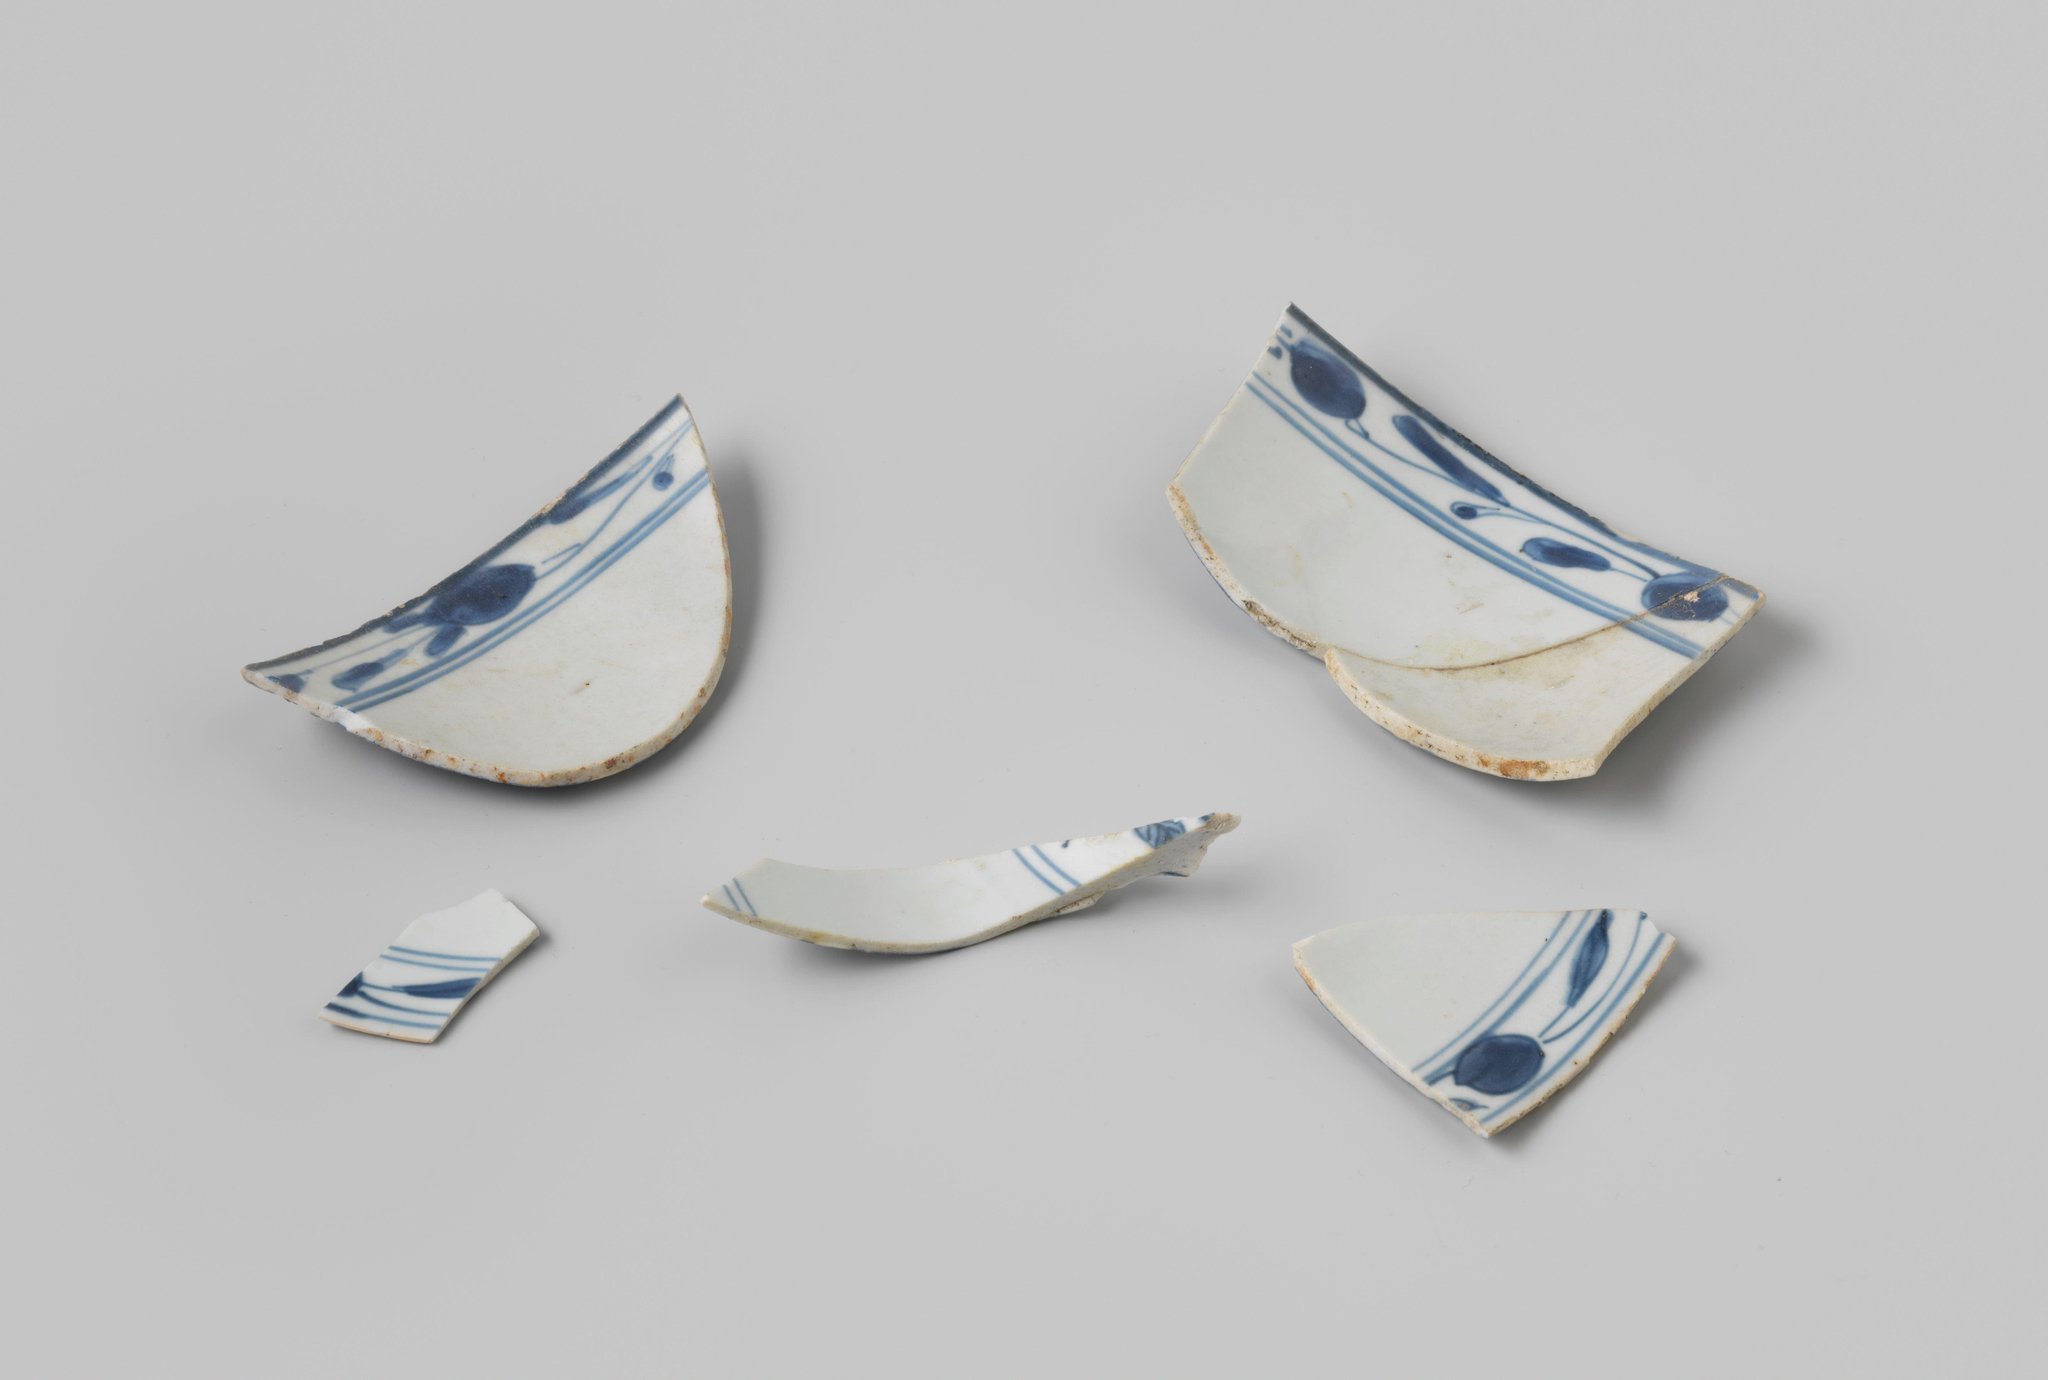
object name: sherd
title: Scherven porselein uit V.O.C.-schip de 'Witte Leeuw'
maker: Anonymous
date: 1613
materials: porcelain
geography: jingdezhen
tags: verenigde oostindische compagnie, sint-helena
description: Scherven porselein van kom uit V.O.C.-schip de 'Witte Leeuw'. Eén fragment bestaat uit twee aan elkaar gelijmde fragmenten.